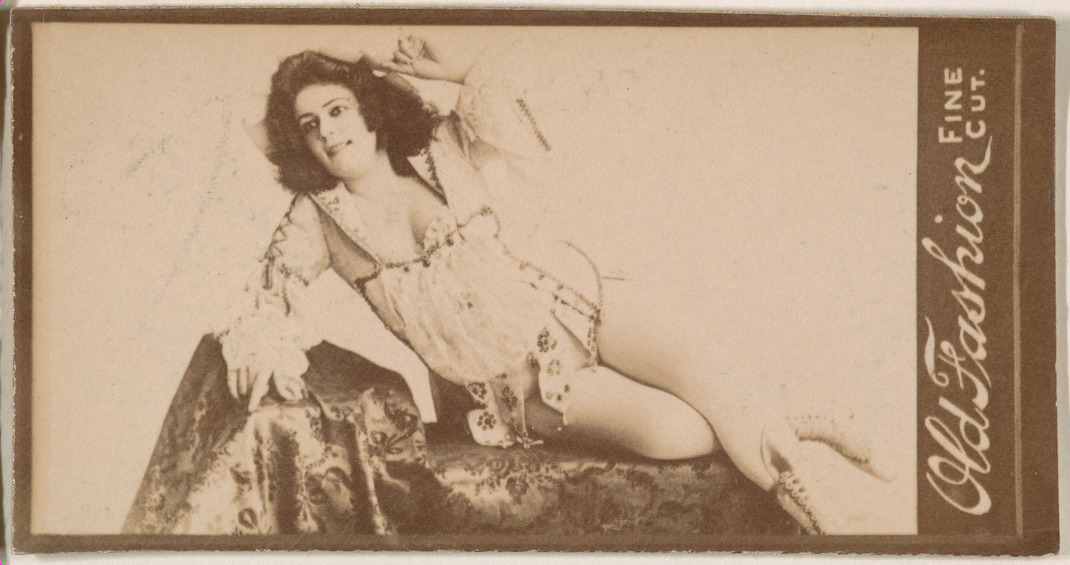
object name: photograph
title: Reclining actress, from the Actresses series (N664) promoting Old Fashion Fine Cut Tobacco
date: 1888-1890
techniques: albumen silver print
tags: portraits,women,actresses